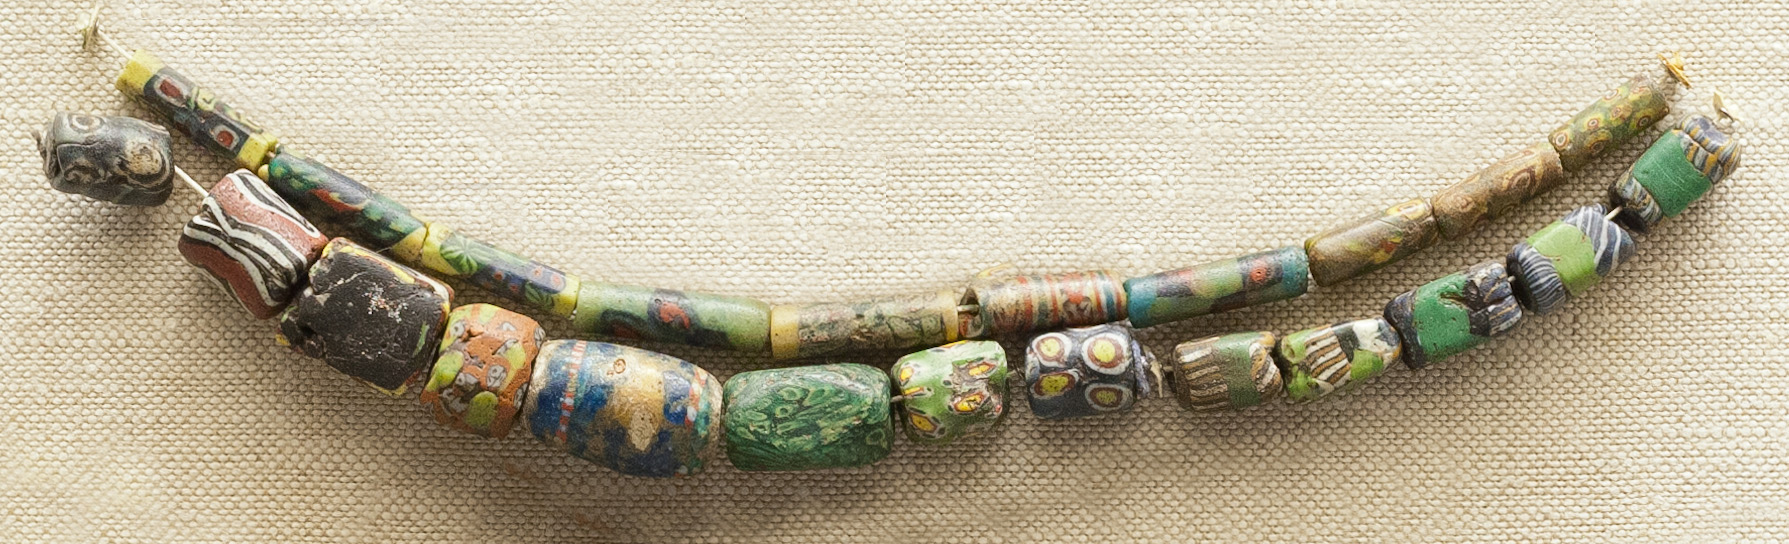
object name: bead, string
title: String of 10 Mosaic Beads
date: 1-100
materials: glass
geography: egypt